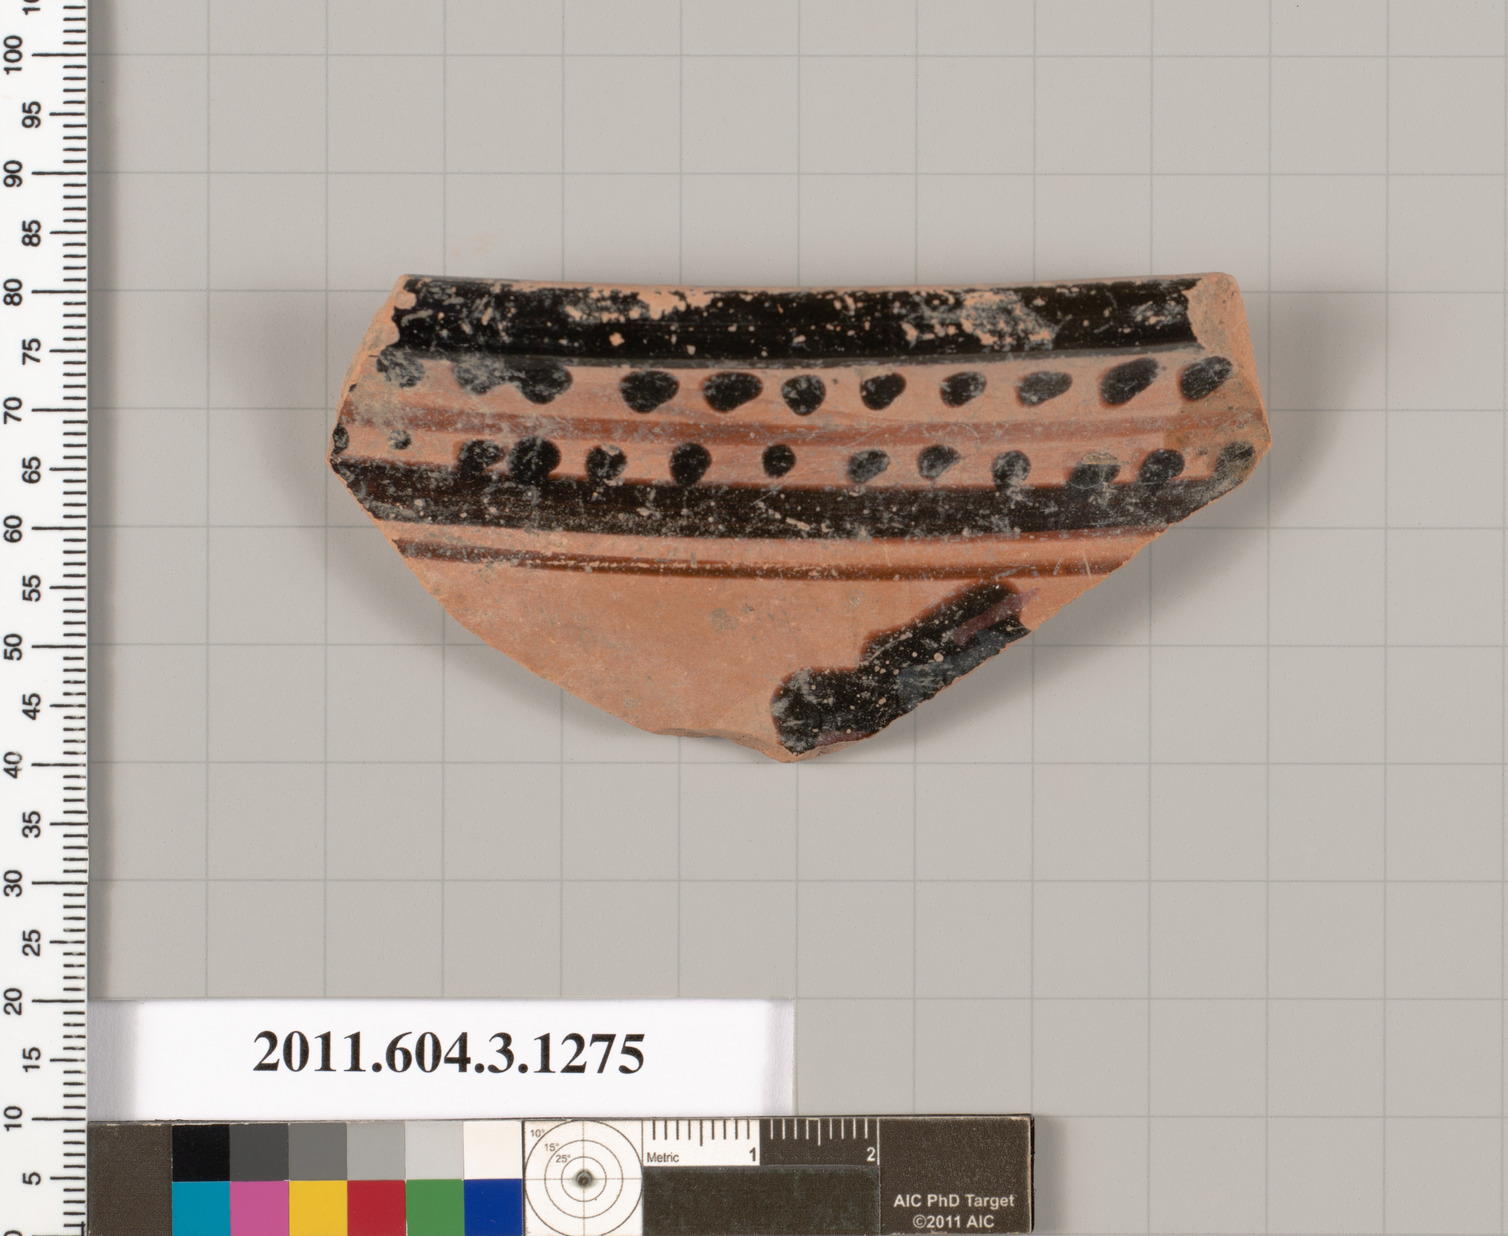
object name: skyphos fragment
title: Terracotta rim fragment of a skyphos (deep drinking cup)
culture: greek, attic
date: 500 BCE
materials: terracotta